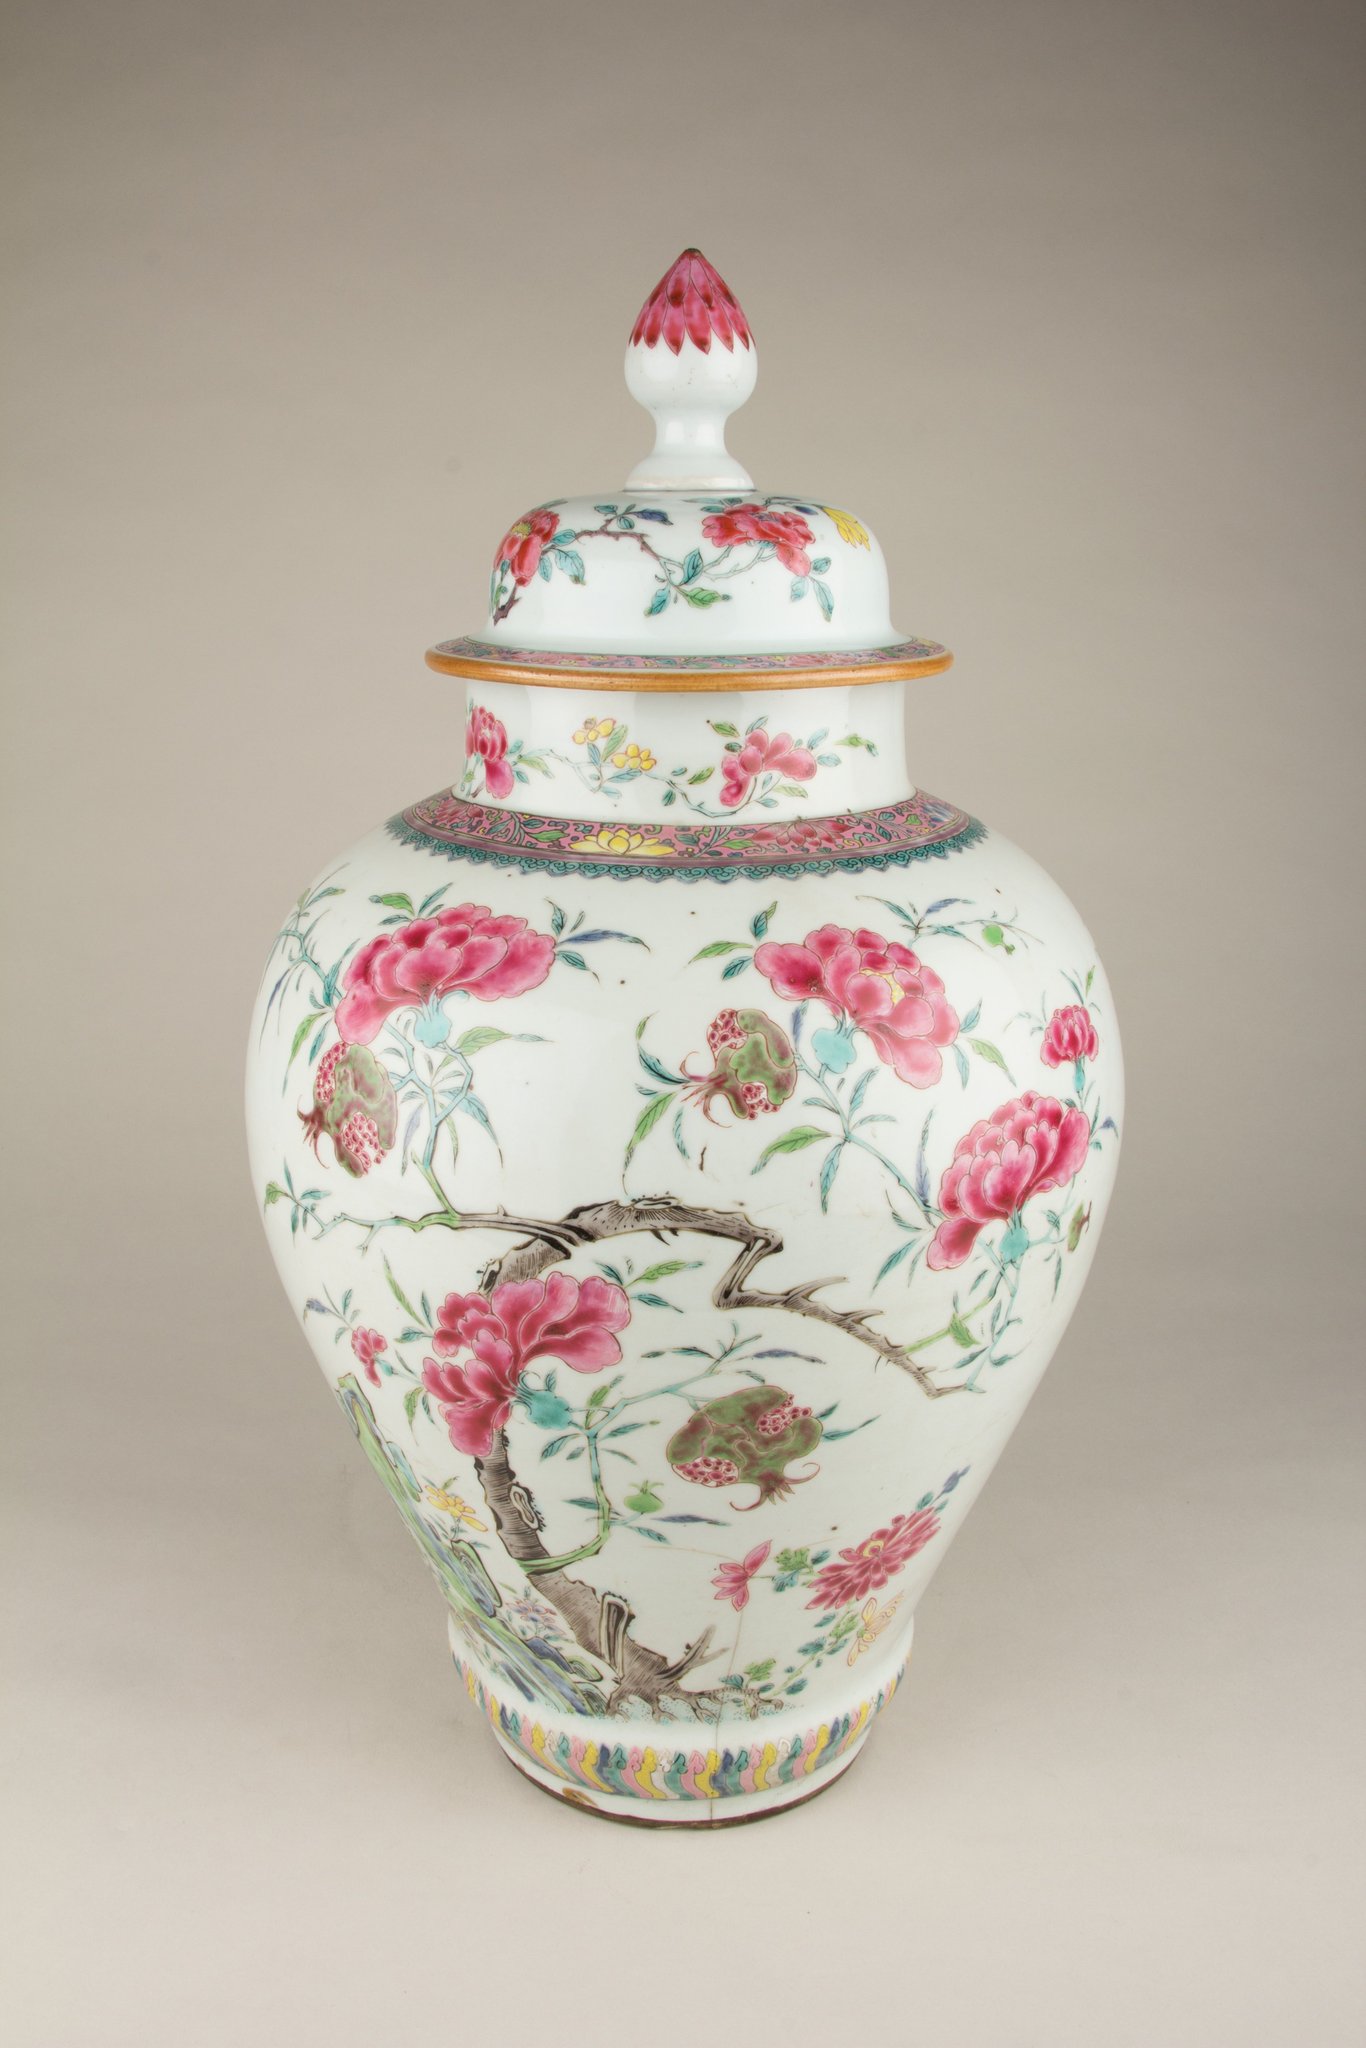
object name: jar with cover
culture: chinese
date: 1736-1795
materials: porcelain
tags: flowers